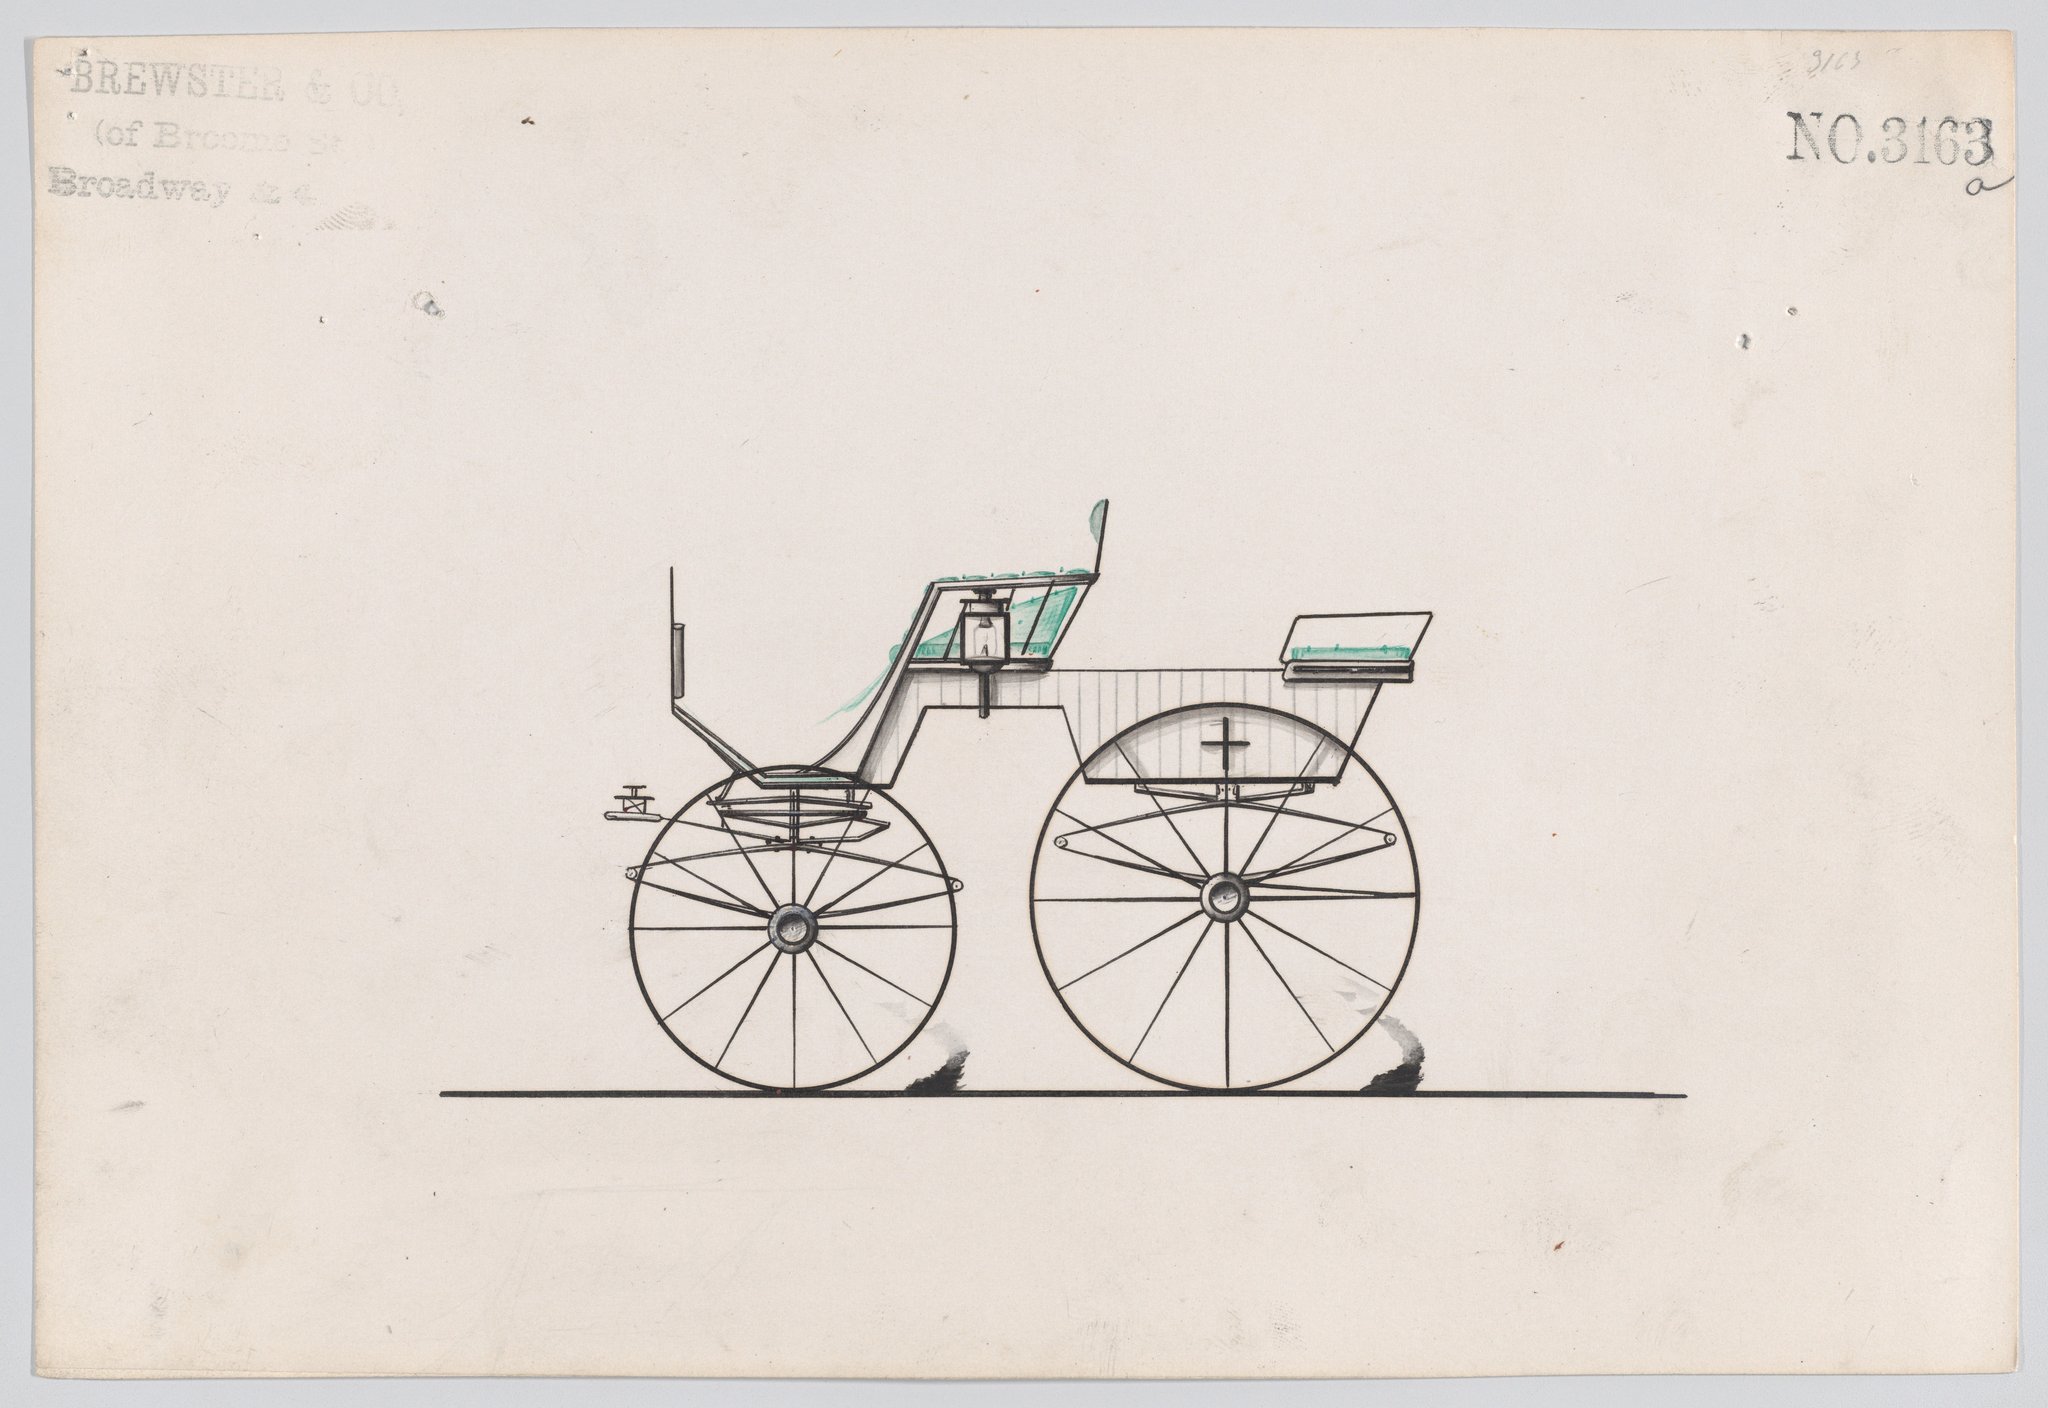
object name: drawing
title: Design for T-Cart, no. 3163a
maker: brewster & co.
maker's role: manufacturer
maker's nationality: american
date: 1875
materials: gouache, ink, watercolor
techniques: pen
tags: carriages